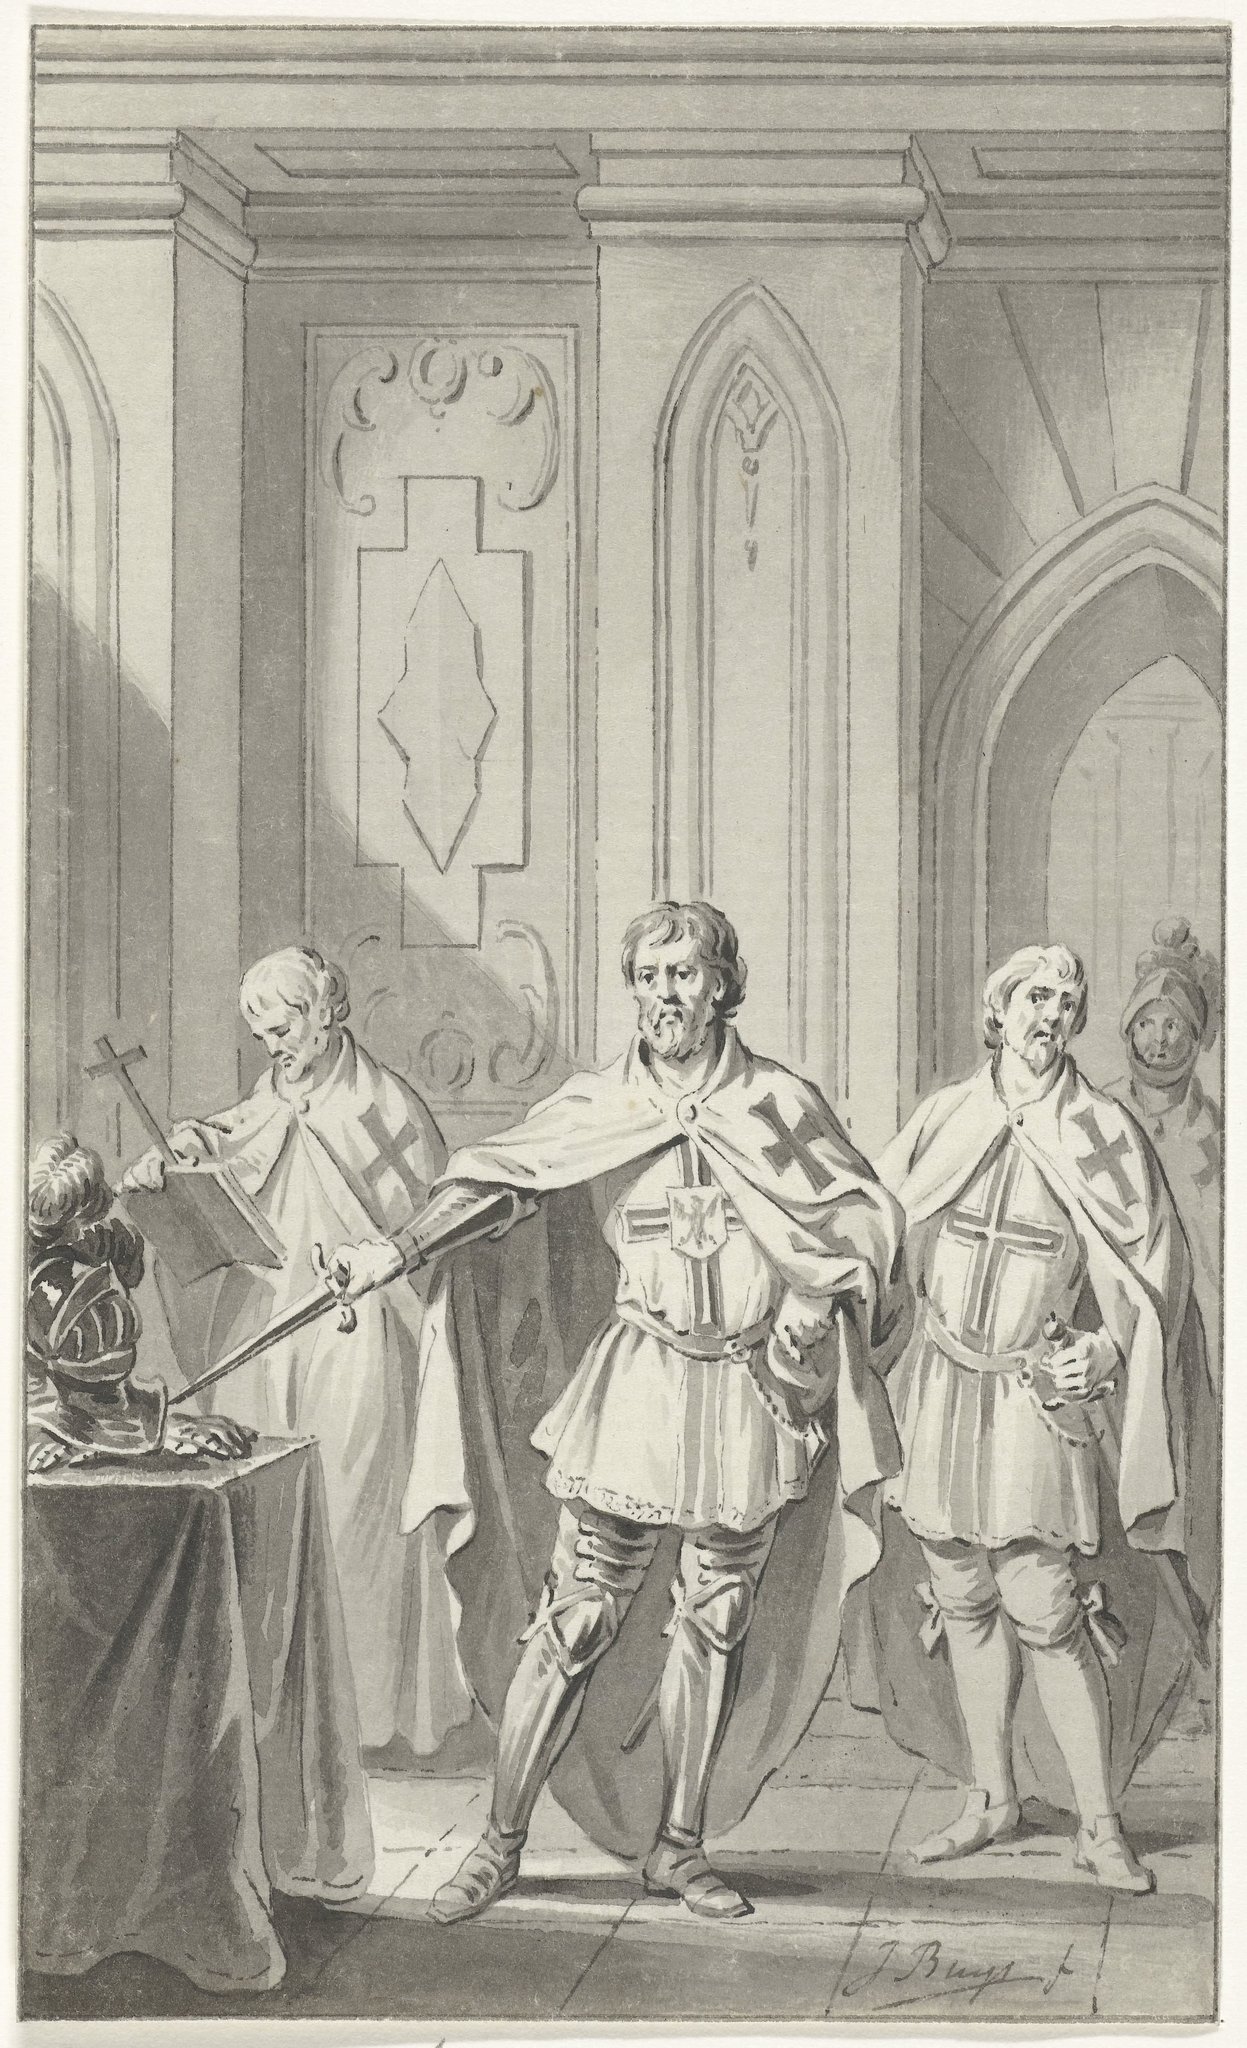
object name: design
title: Ridders van het Duitse Kruis, 1180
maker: jacobus buys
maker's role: draughtsman, print maker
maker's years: 1724-1801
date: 1781-1783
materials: ink, paper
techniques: brush, pen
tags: military orders, e.g.: knights templars, knights of malta, teutonic knights ~ roman catholic church, knight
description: Ontwerptekening voor illustratie in: Jacobus Kok, Vaderlandsch Woordenboek, Johannes Allart, Amsterdam 1785-1799, 35 delen, dl. XIII, pl. I.